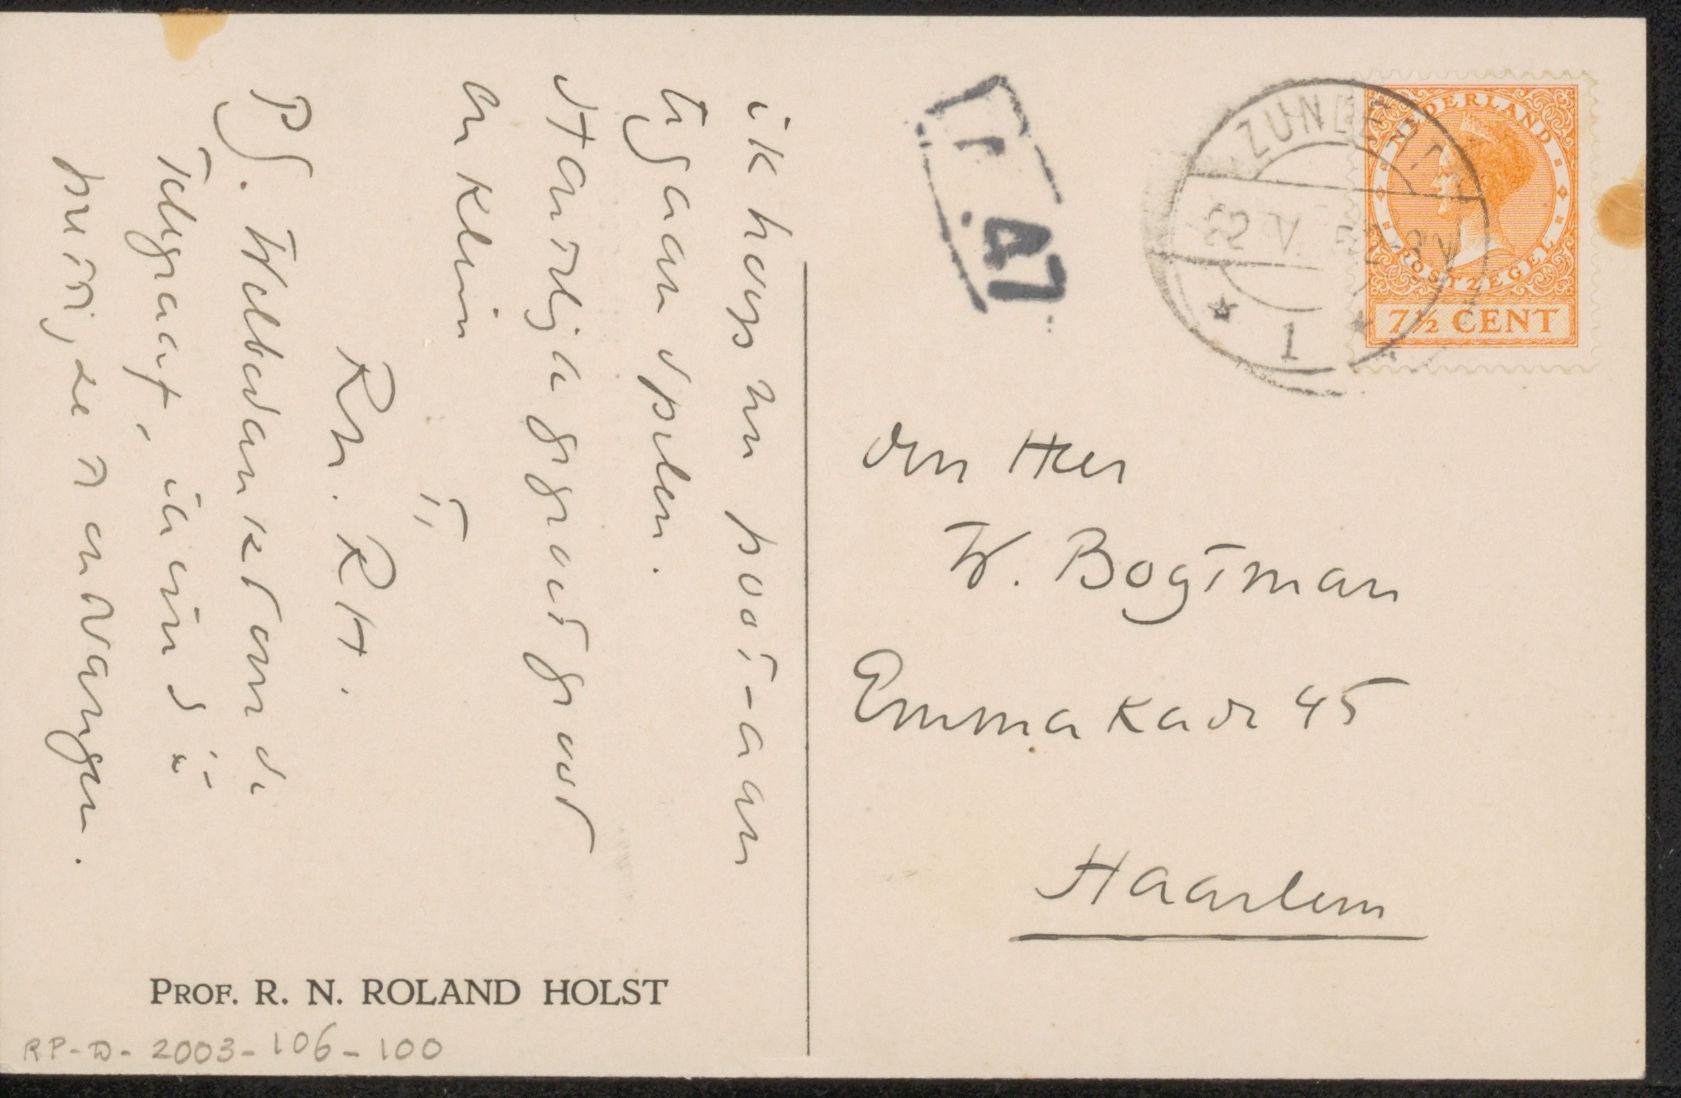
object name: ansichtkaart, prentbriefkaart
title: Prentbriefkaart aan Willem Bogtman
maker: richard nicolaüs roland holst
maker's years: 1868-1938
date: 1925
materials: ink, paper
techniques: pen, writing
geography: zundert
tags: haarlem, willem bogtman, education, tuition of the artist (in general), paris, amsterdam